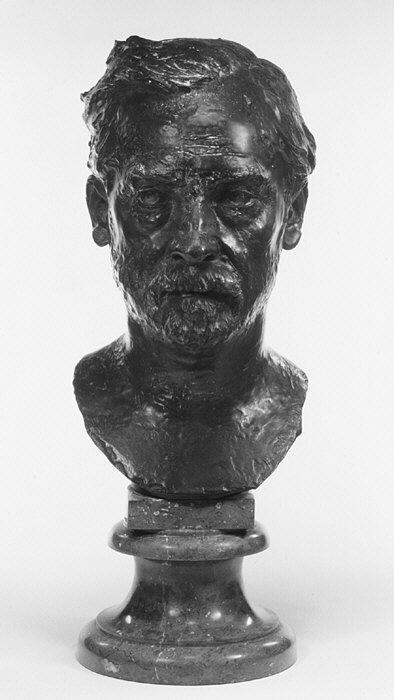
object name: bust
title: Louis Pasteur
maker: paul dubois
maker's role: artist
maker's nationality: french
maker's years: 1829-1905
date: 1889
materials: bronze, marble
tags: men